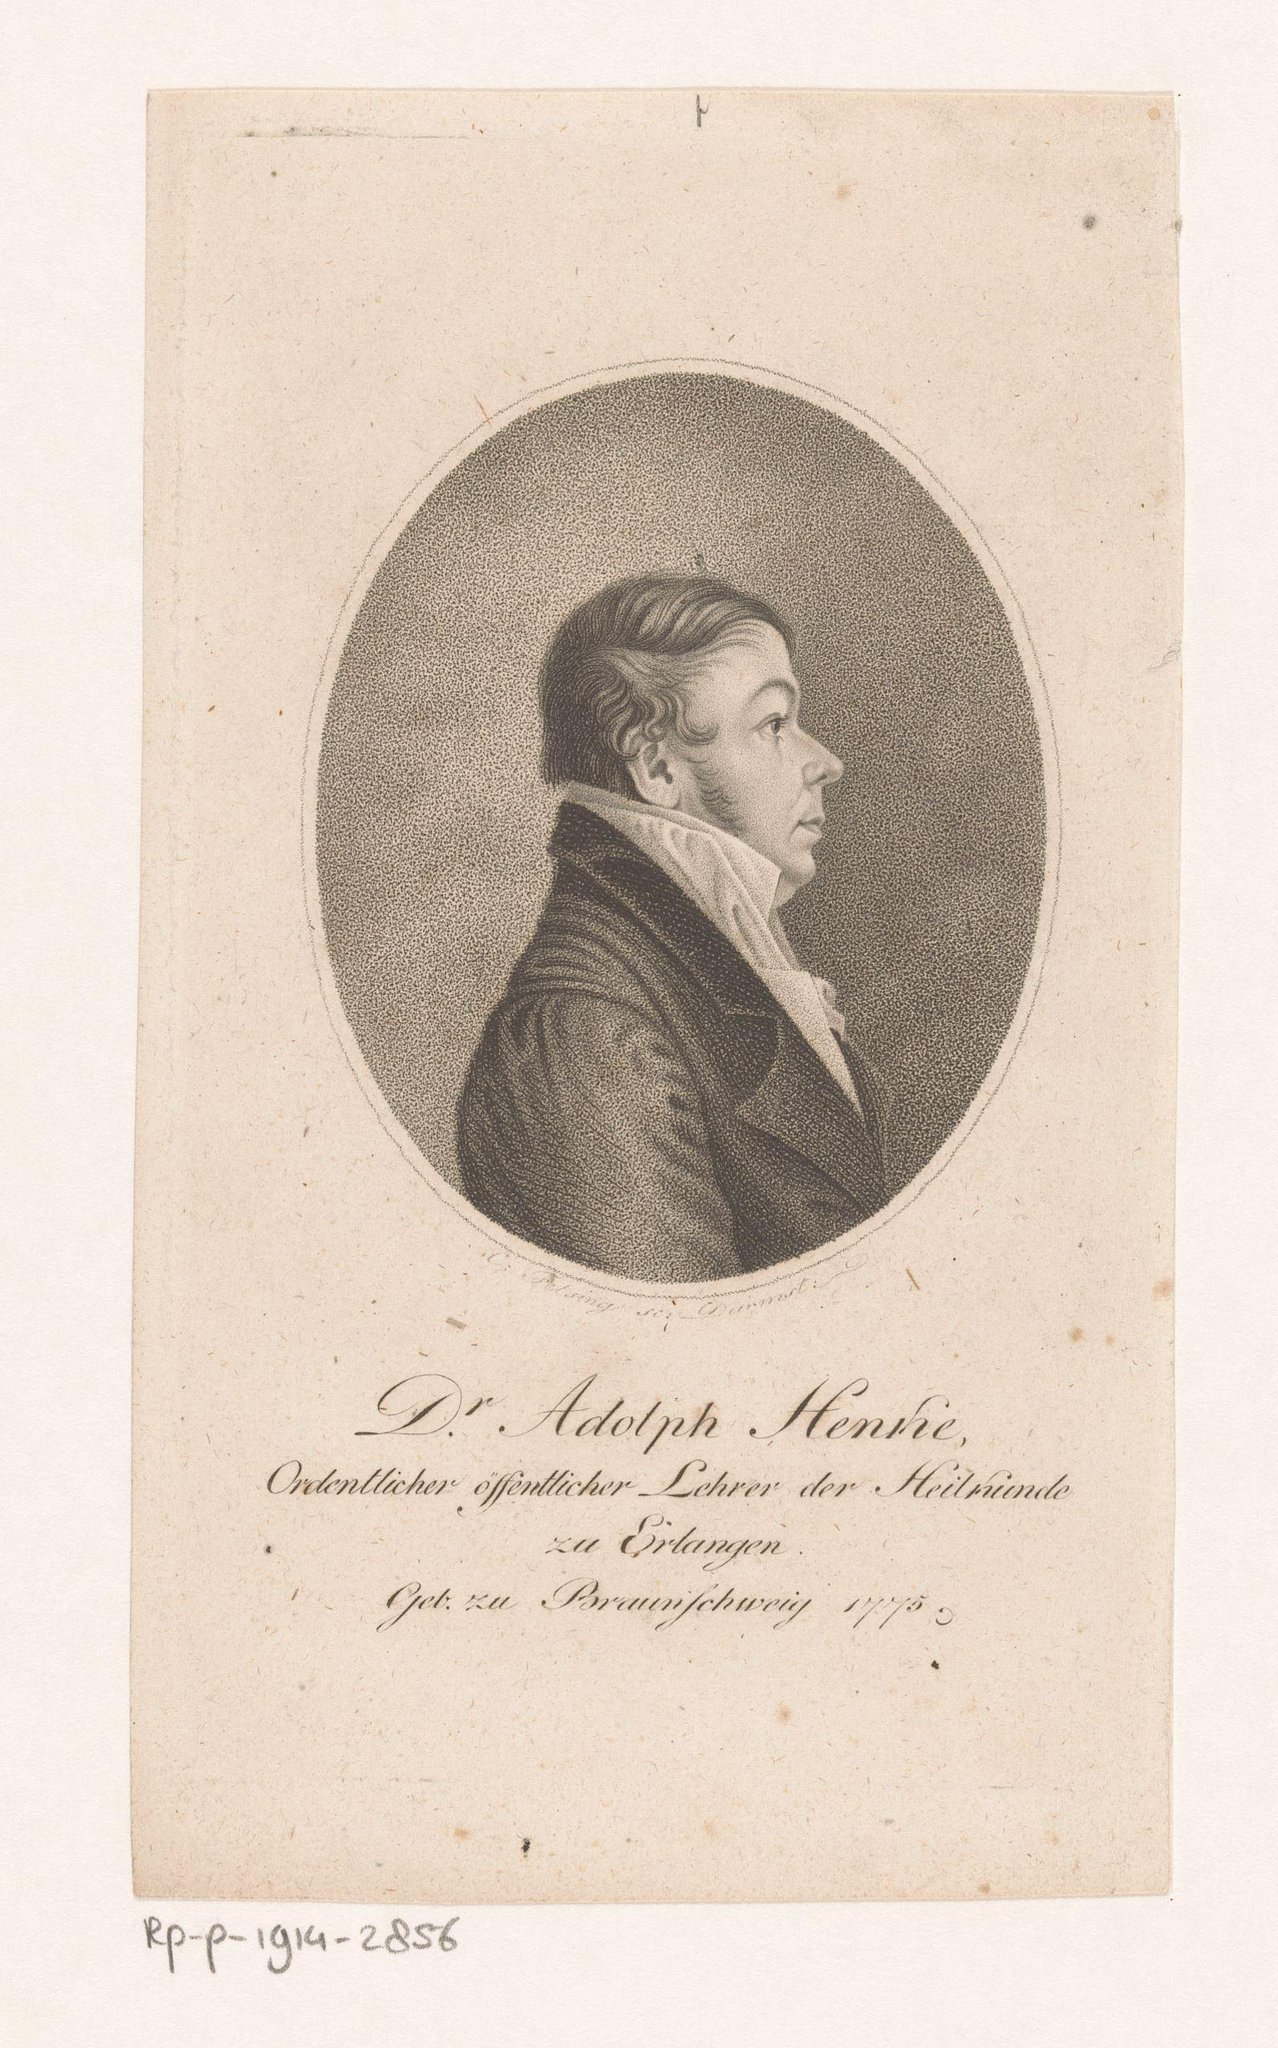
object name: print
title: Portret van Adolf Henke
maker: conrad felsing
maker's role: print maker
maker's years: 1766-1819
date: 1785-1819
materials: paper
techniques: engraving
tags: historical persons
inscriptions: collector's mark: Lugt 2228